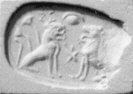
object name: stamp seal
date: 600-301 BCE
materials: stone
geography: levant or syria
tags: animals